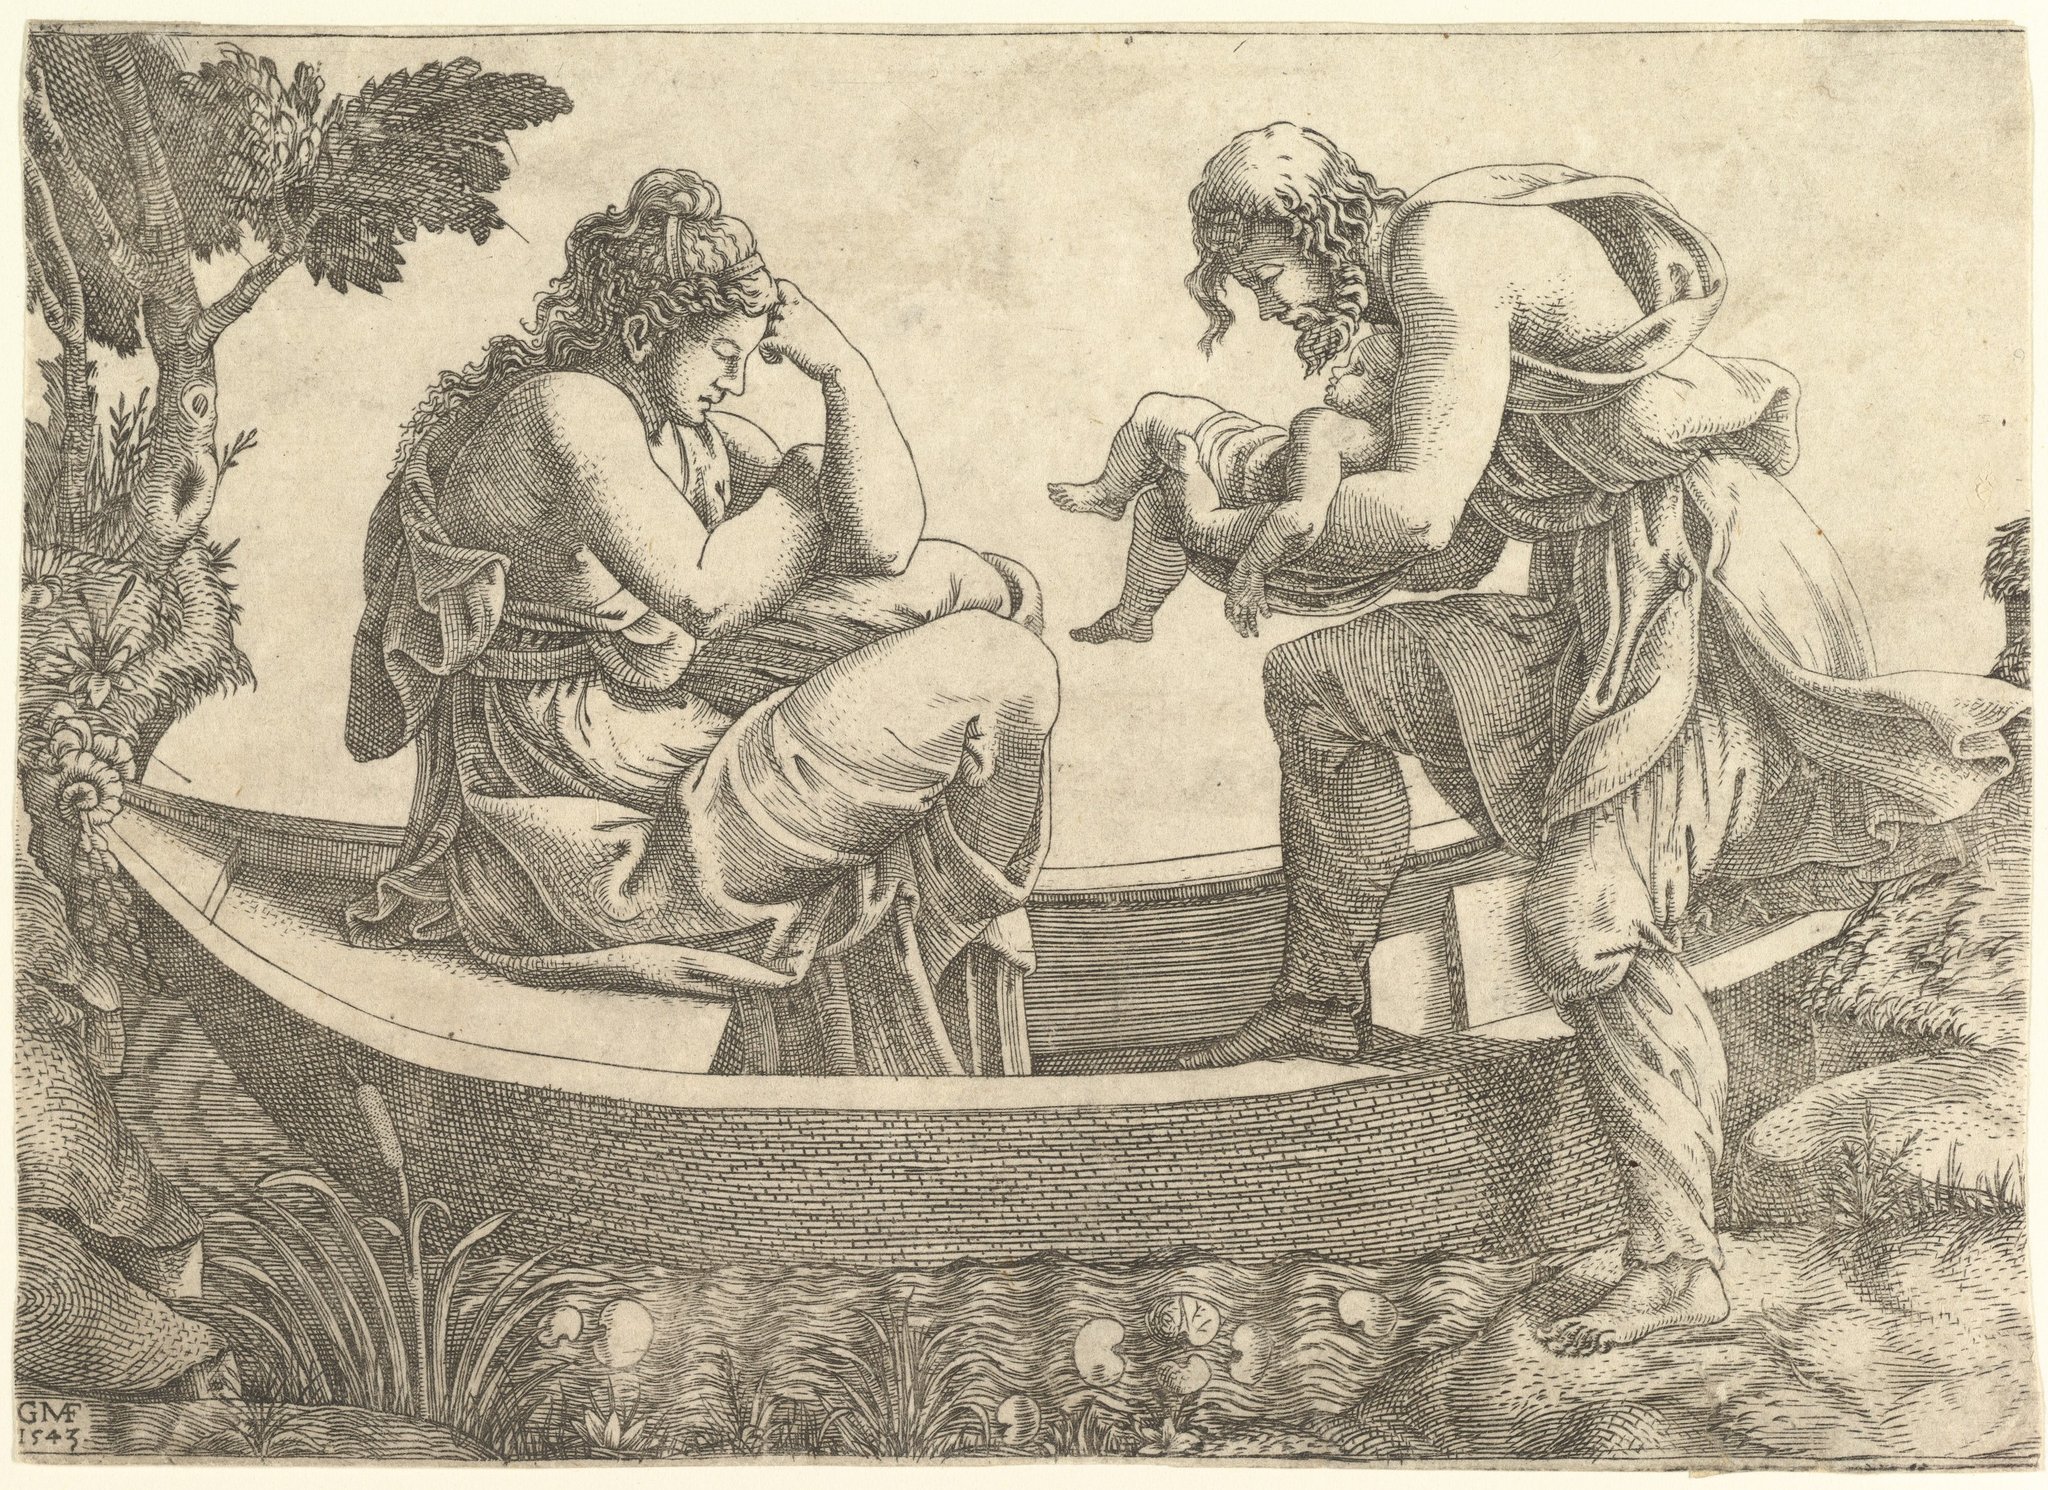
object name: print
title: Danae and the infant Perseus cast out to sea by Acrisius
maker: giorgio ghisi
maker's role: artist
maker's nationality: italian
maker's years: 1515-1582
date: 1543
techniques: engraving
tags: kings,infants,women,perseus,boats